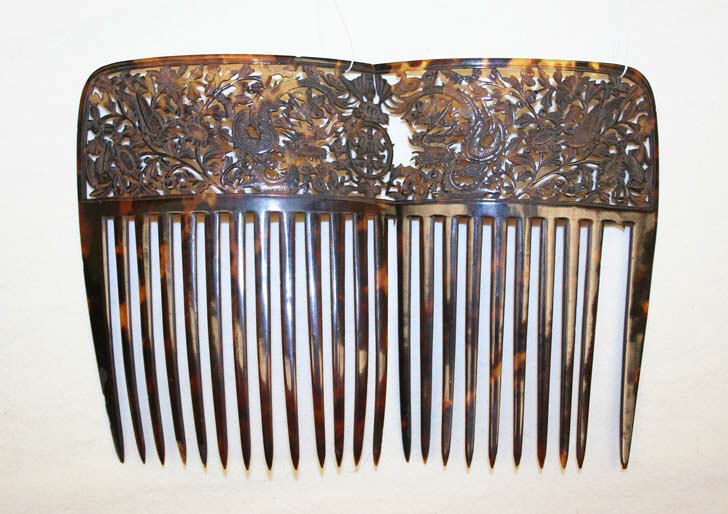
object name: comb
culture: american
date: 1801-1900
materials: shell